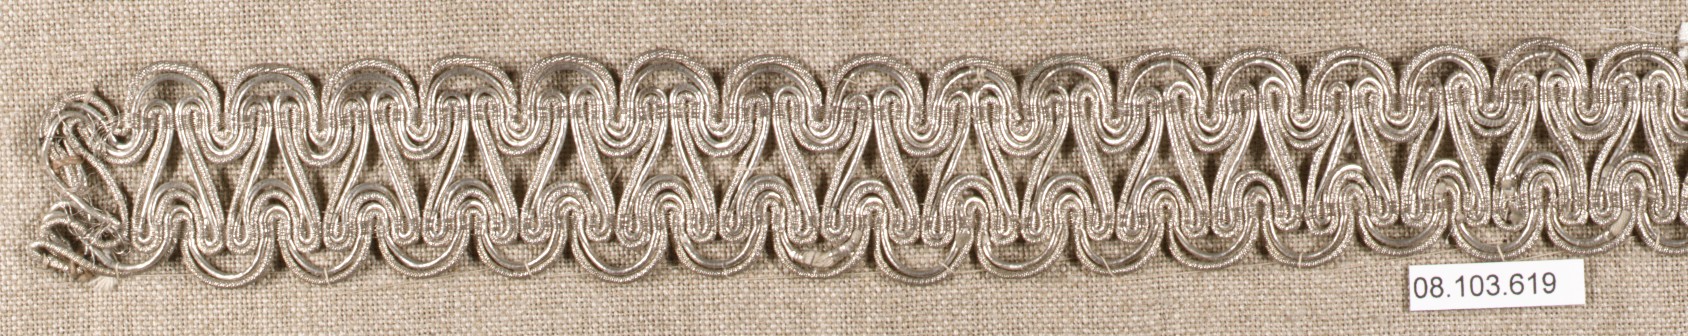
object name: galloon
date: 1601-1700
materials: metal thread